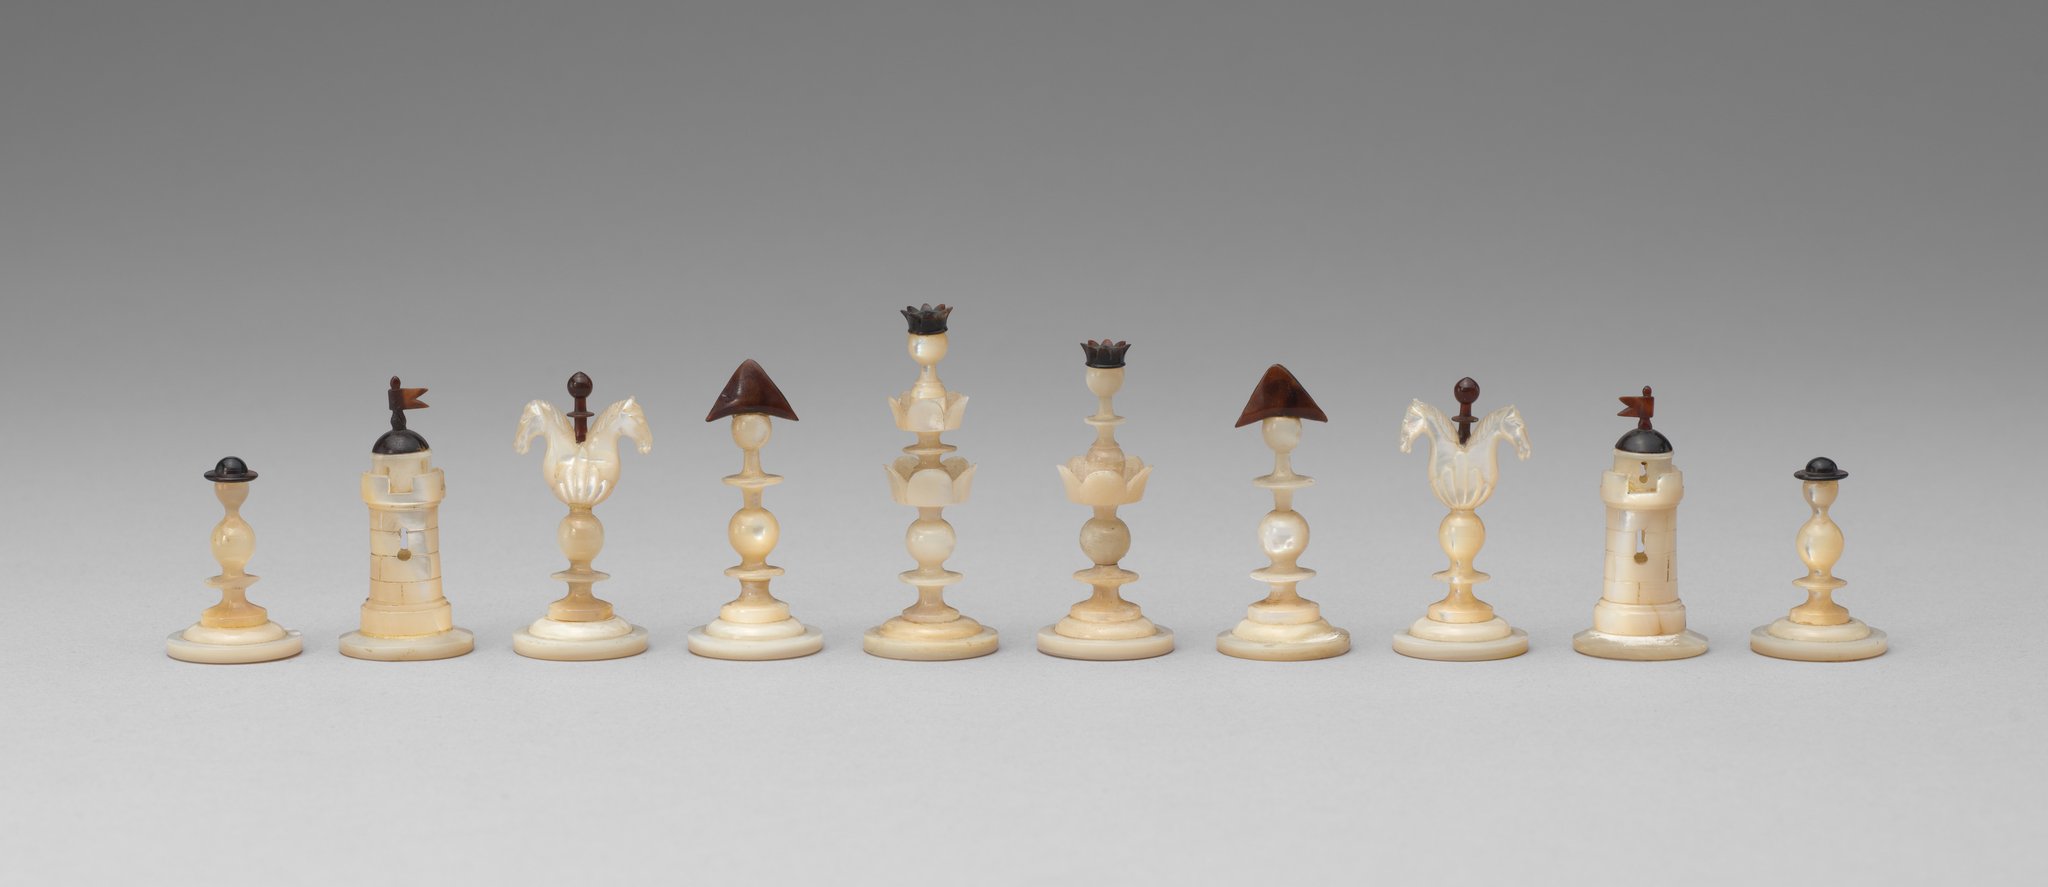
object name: chessman and box board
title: Chessmen (32) and box-board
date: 1801-1900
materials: mother of pearl, shell, wood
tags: chess